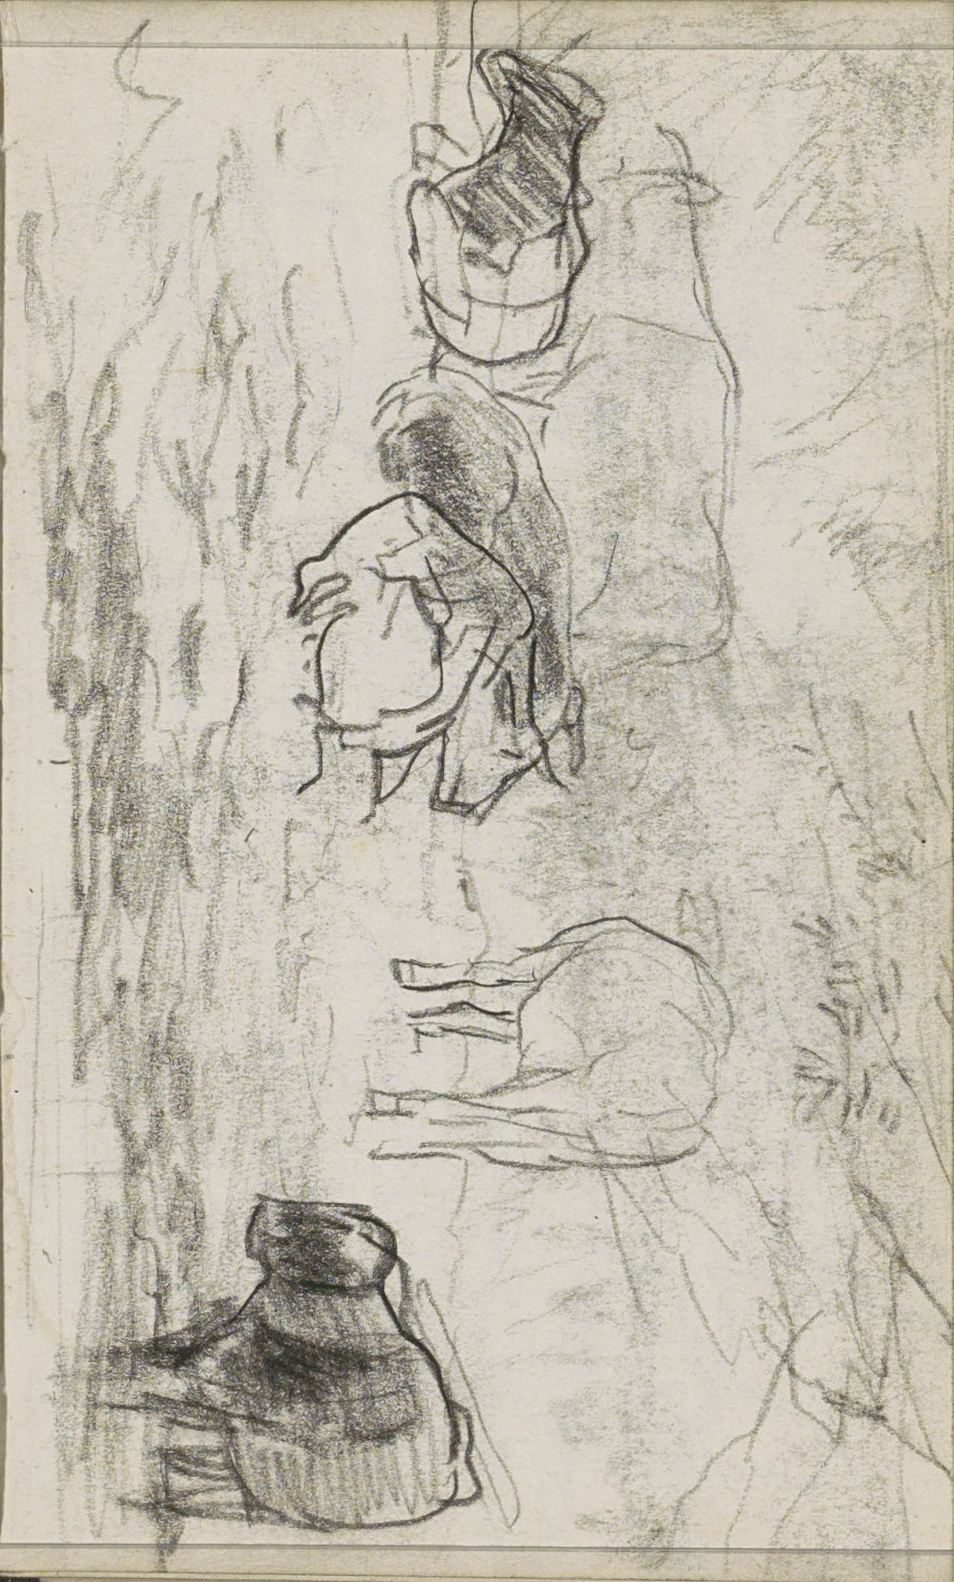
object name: sketchbook leaf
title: Koeien in een weide aan een waterkant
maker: anton mauve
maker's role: draughtsman, painter, print maker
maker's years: 1838-1888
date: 1848-1888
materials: chalk, paper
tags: cow, river bank, meadow, pasture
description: Blad 15 recto uit een schetsboek met 53 bladen.